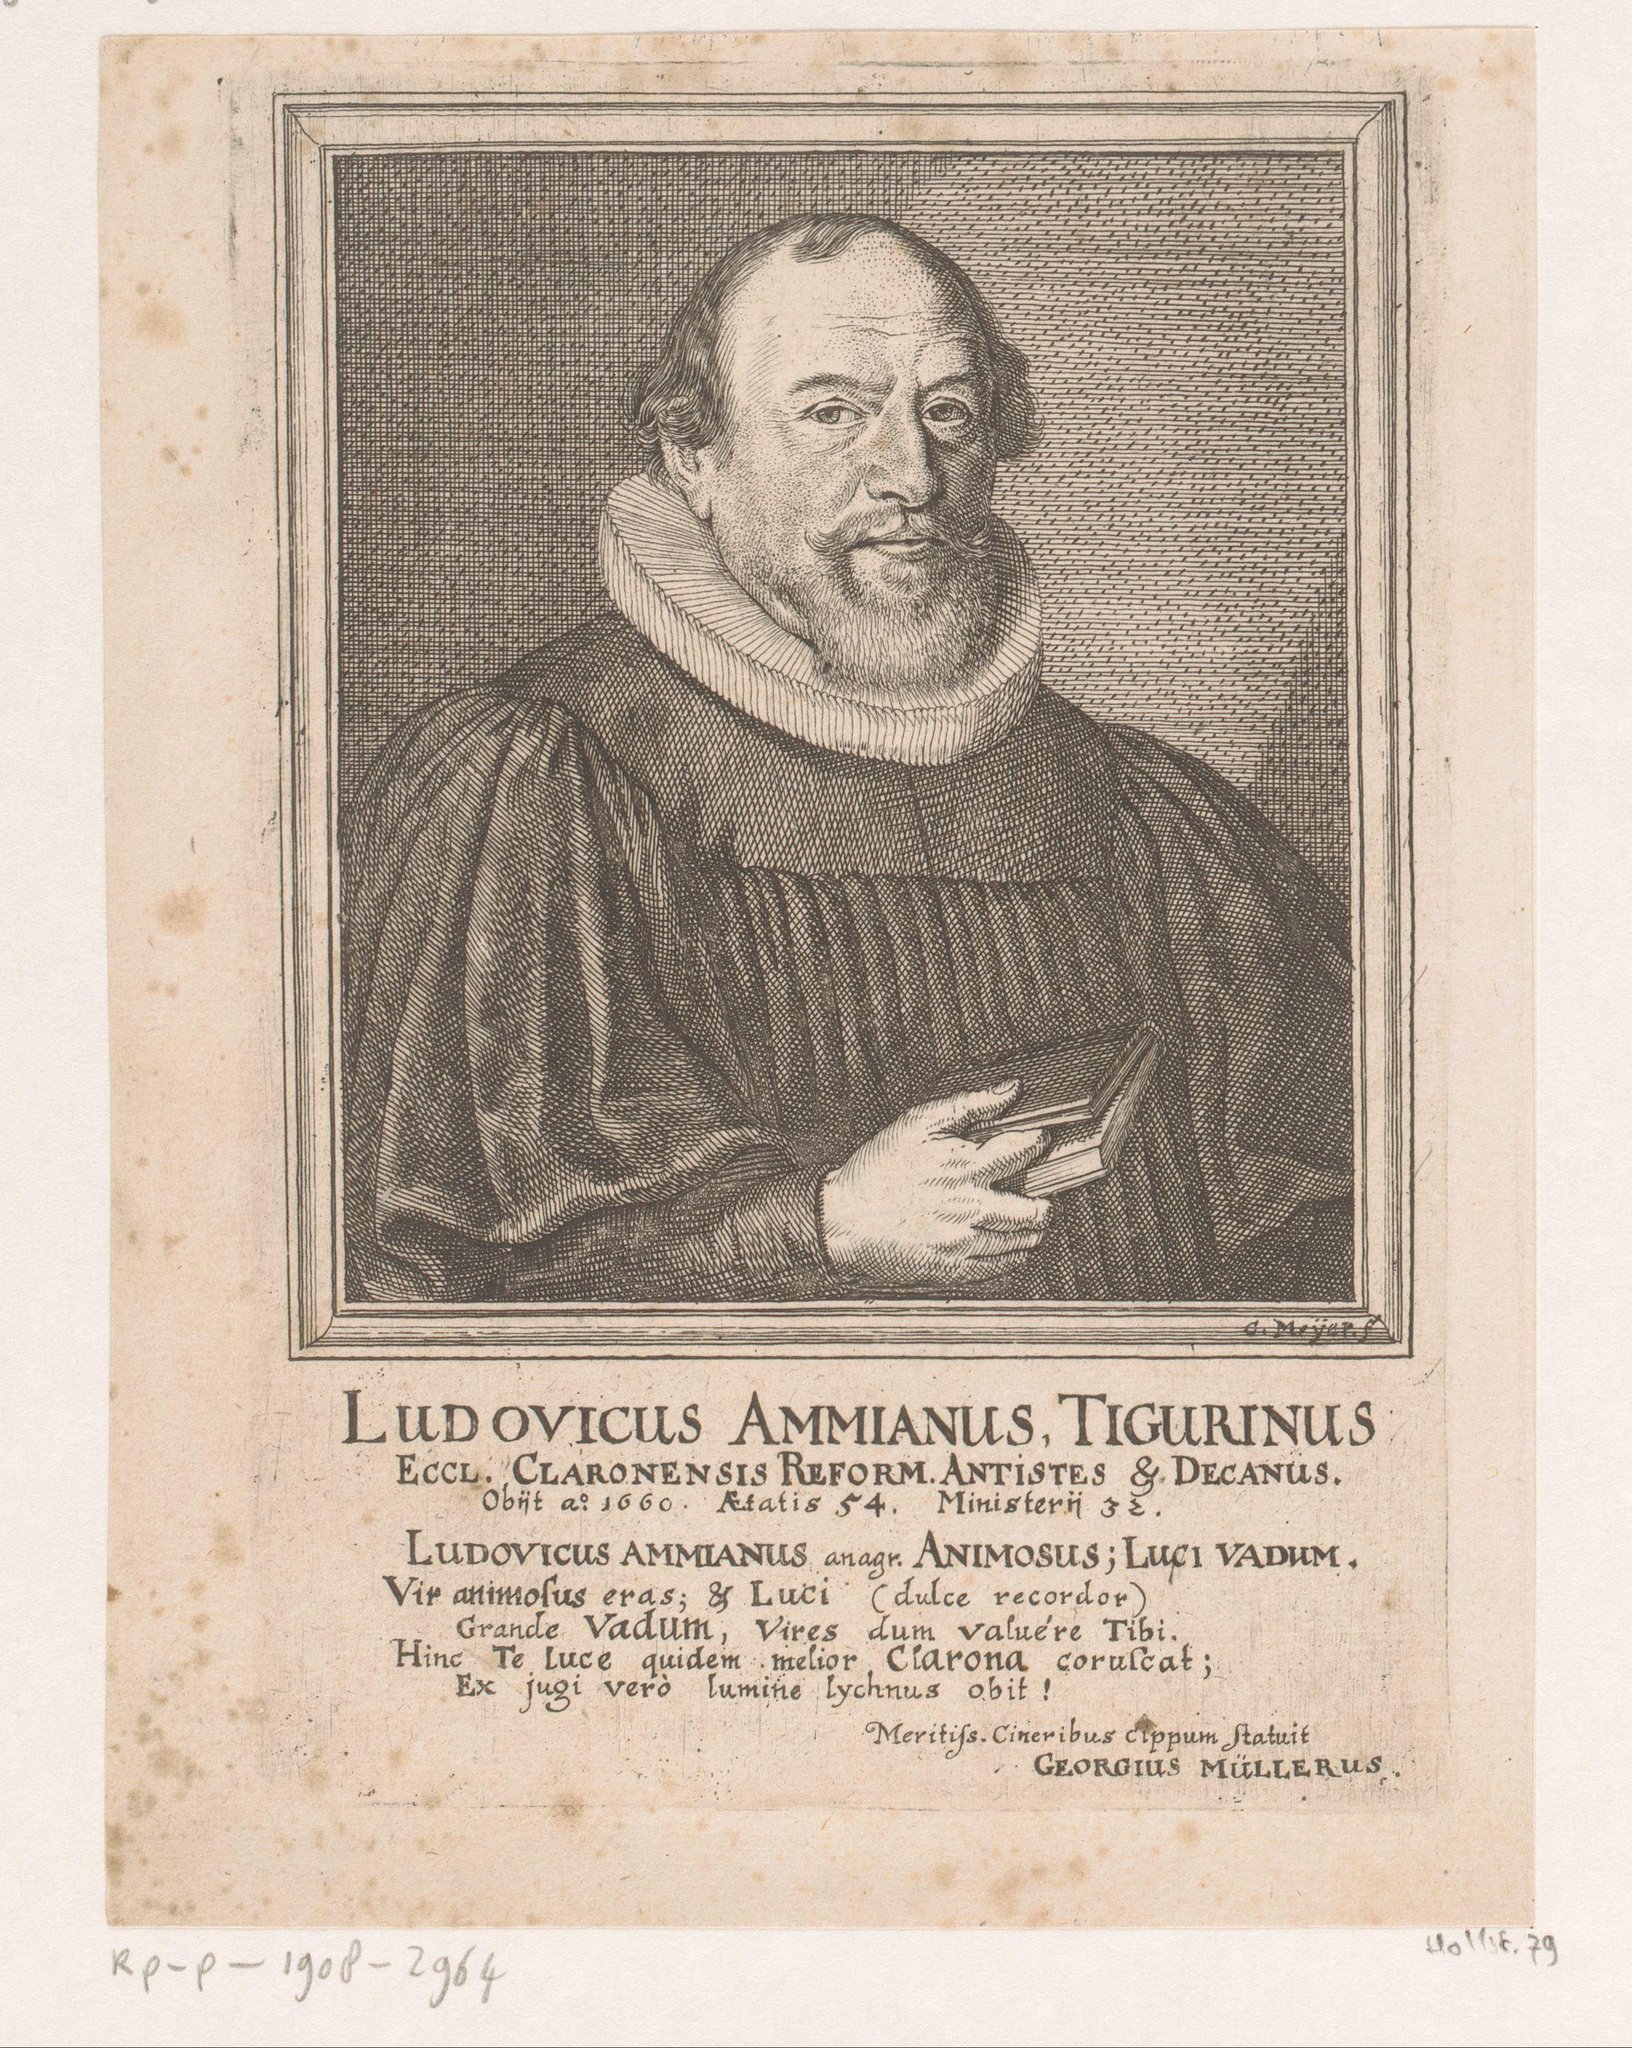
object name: print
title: Portret van Johann Ludwig Amman op 54-jarige leeftijd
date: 1660-1689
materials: paper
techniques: engraving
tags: theologian, historical persons, book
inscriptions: collector's mark: Lugt 2228